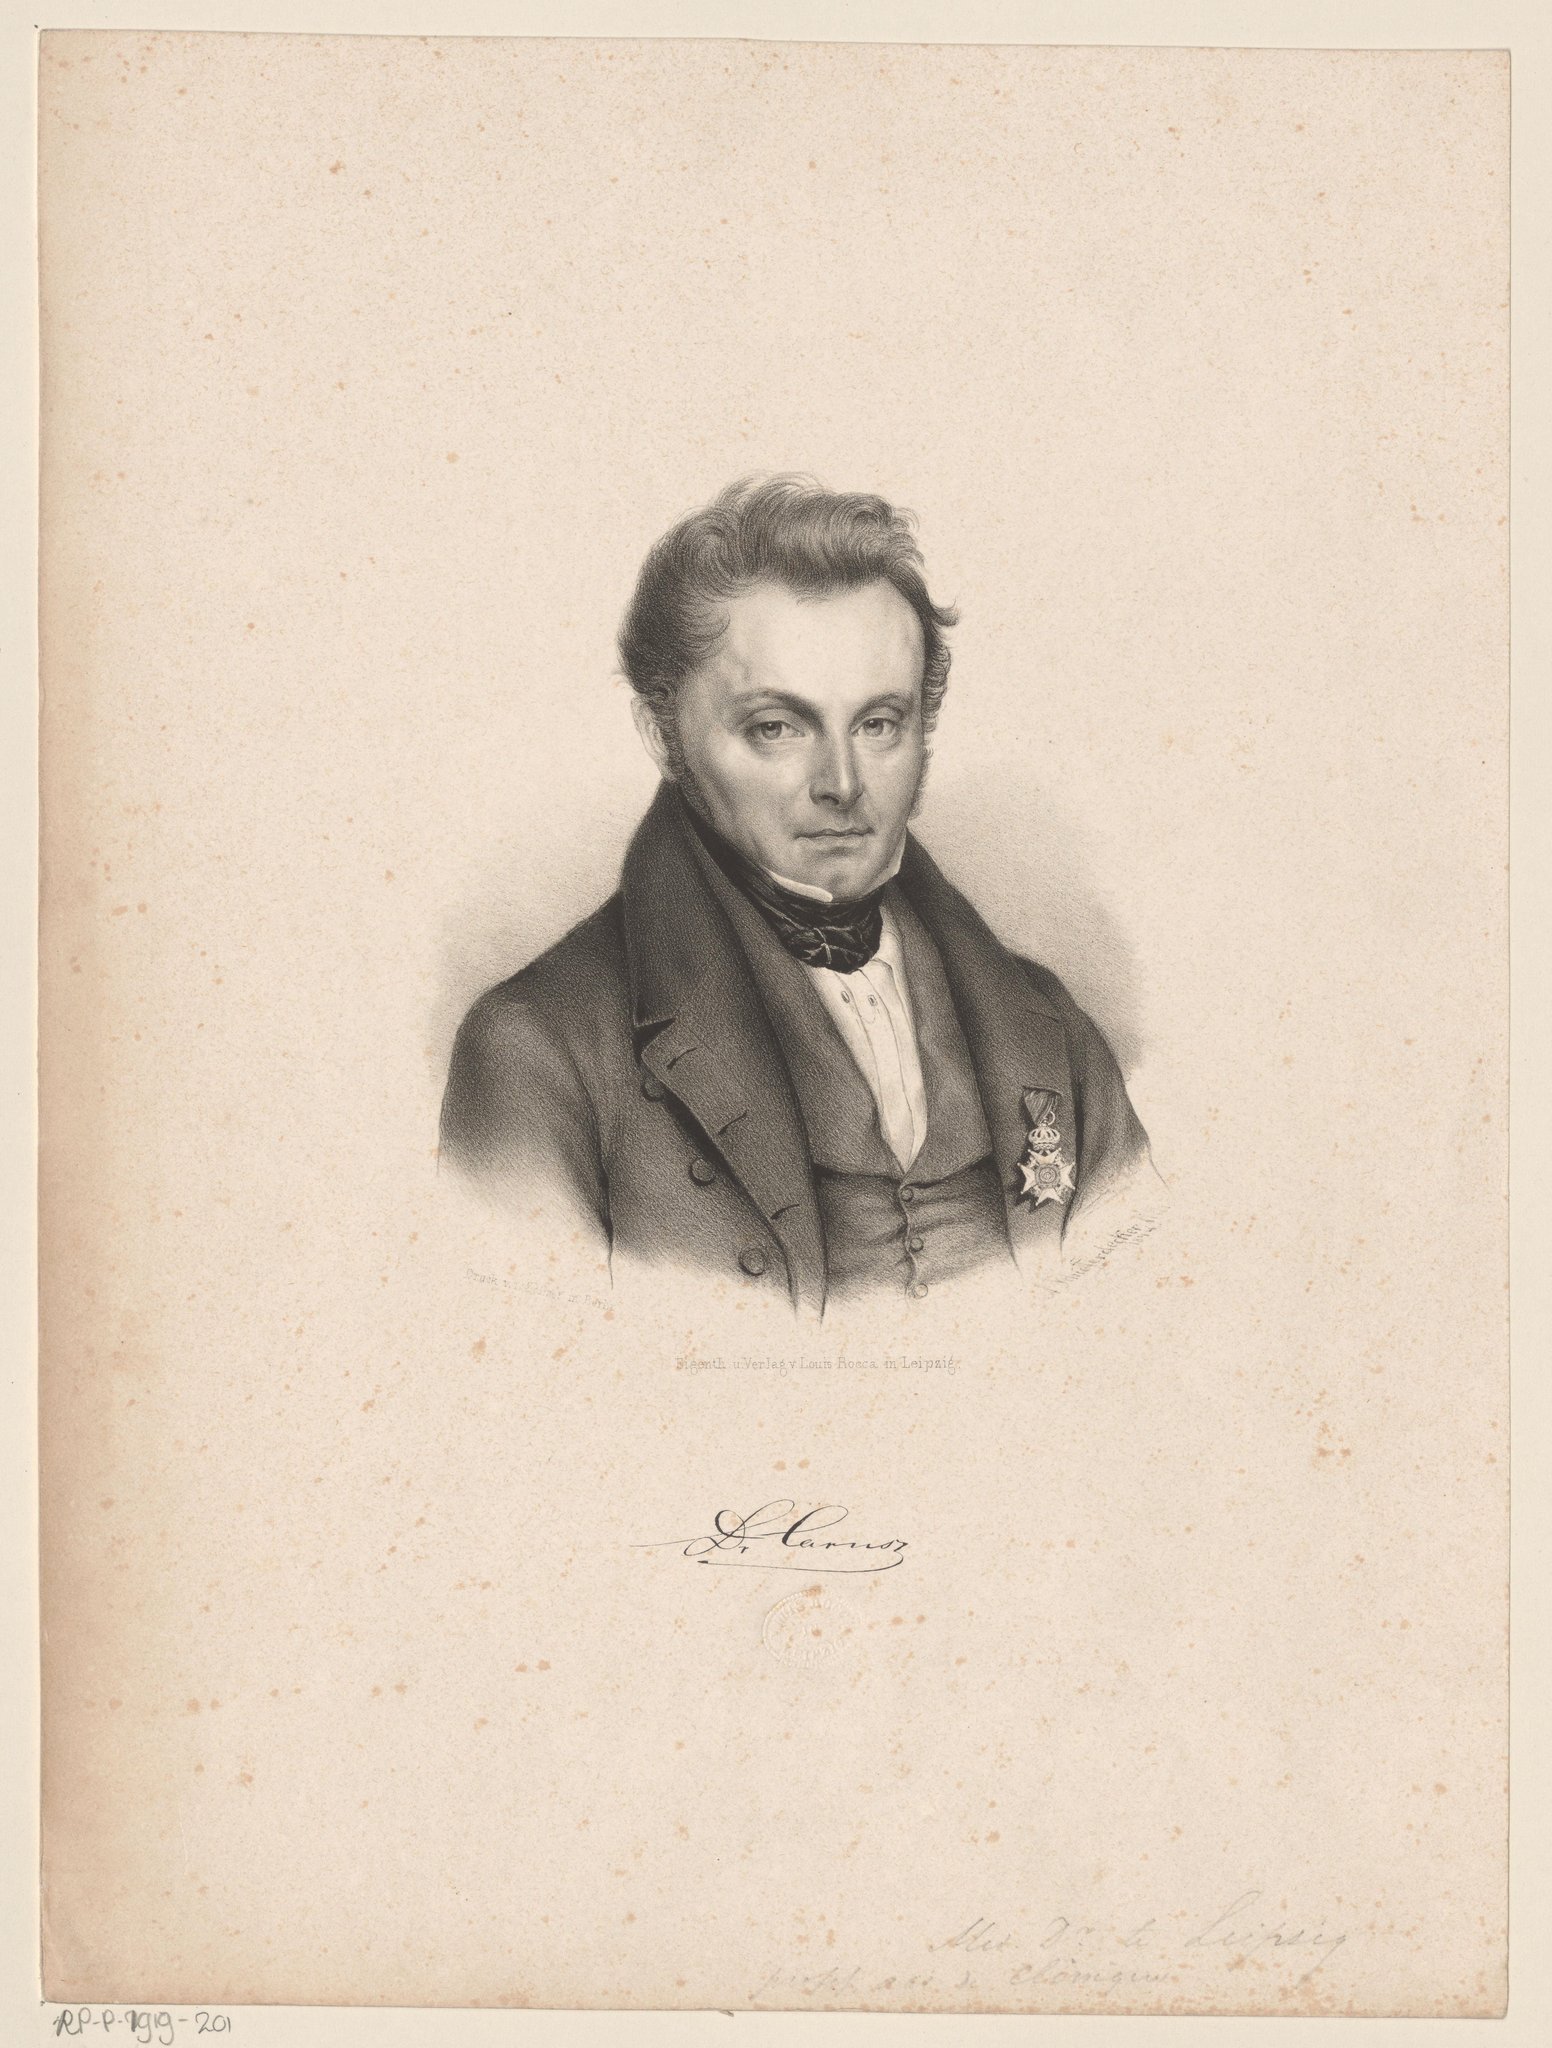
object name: print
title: Portret van Carl Gustav Carus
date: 1844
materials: paper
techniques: lithograph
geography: leipzig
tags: historical persons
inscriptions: check stamp: ‘Louis Rocca in Leipzig’, collector's mark: Lugt 2228